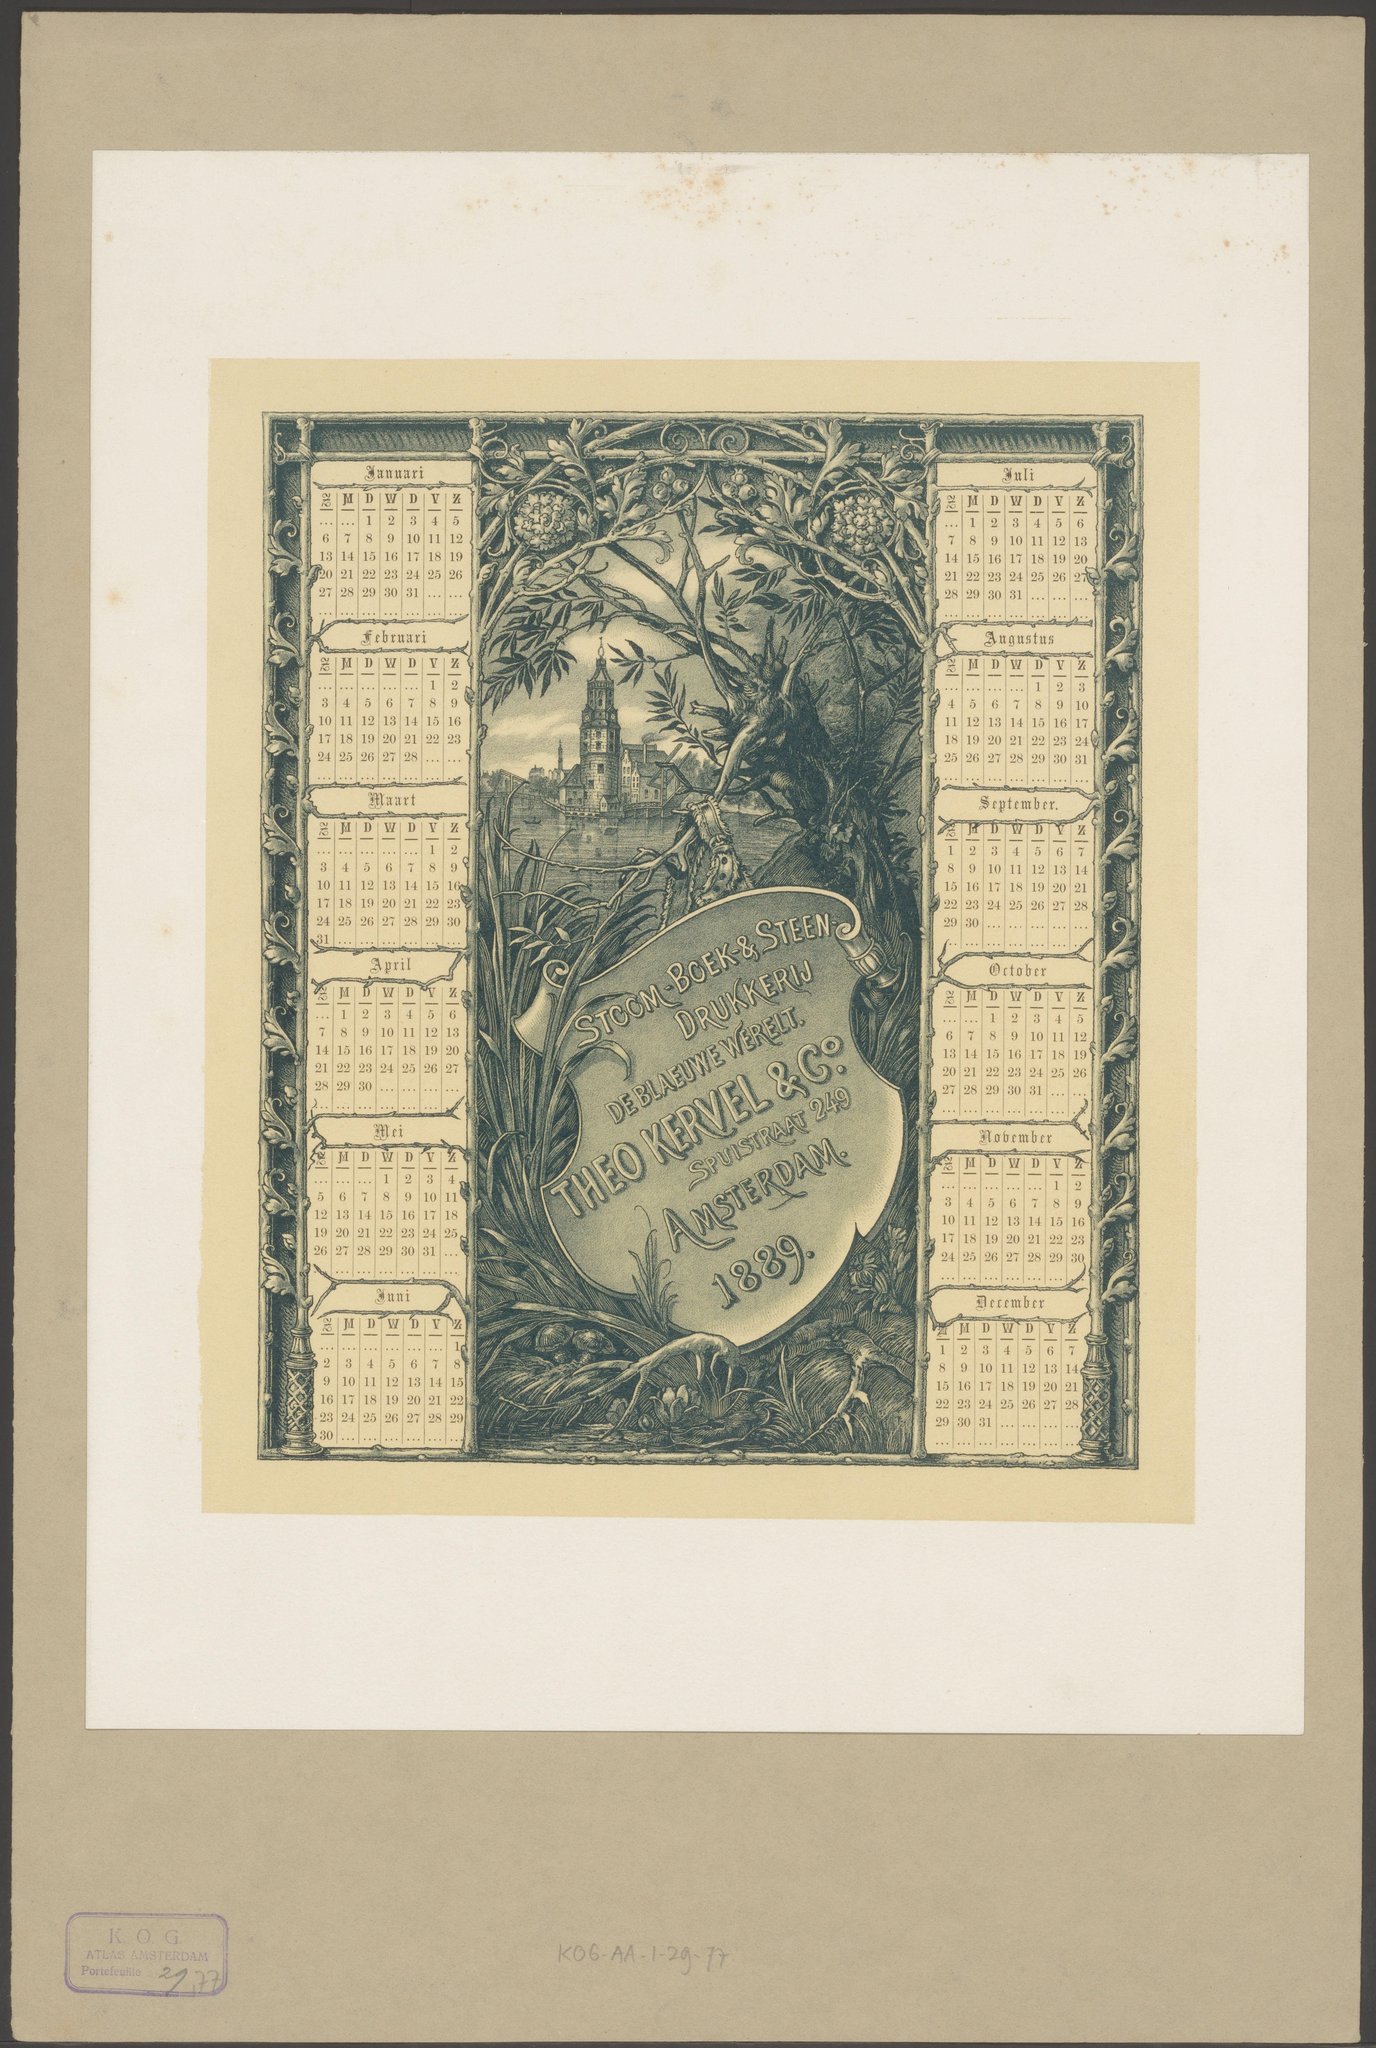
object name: calendar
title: Gezicht op de Montelbaanstoren te Amsterdam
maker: Anonymous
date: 1888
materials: paper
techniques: letterpress printing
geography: amsterdam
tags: protective weapons: shield, trees, tower, clock tower ~ monumental adornment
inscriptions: collector's mark: Lugt 1641b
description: Onderwerpsrubriek binnen de Atlas Amsterdam: Montelbaanstoren.